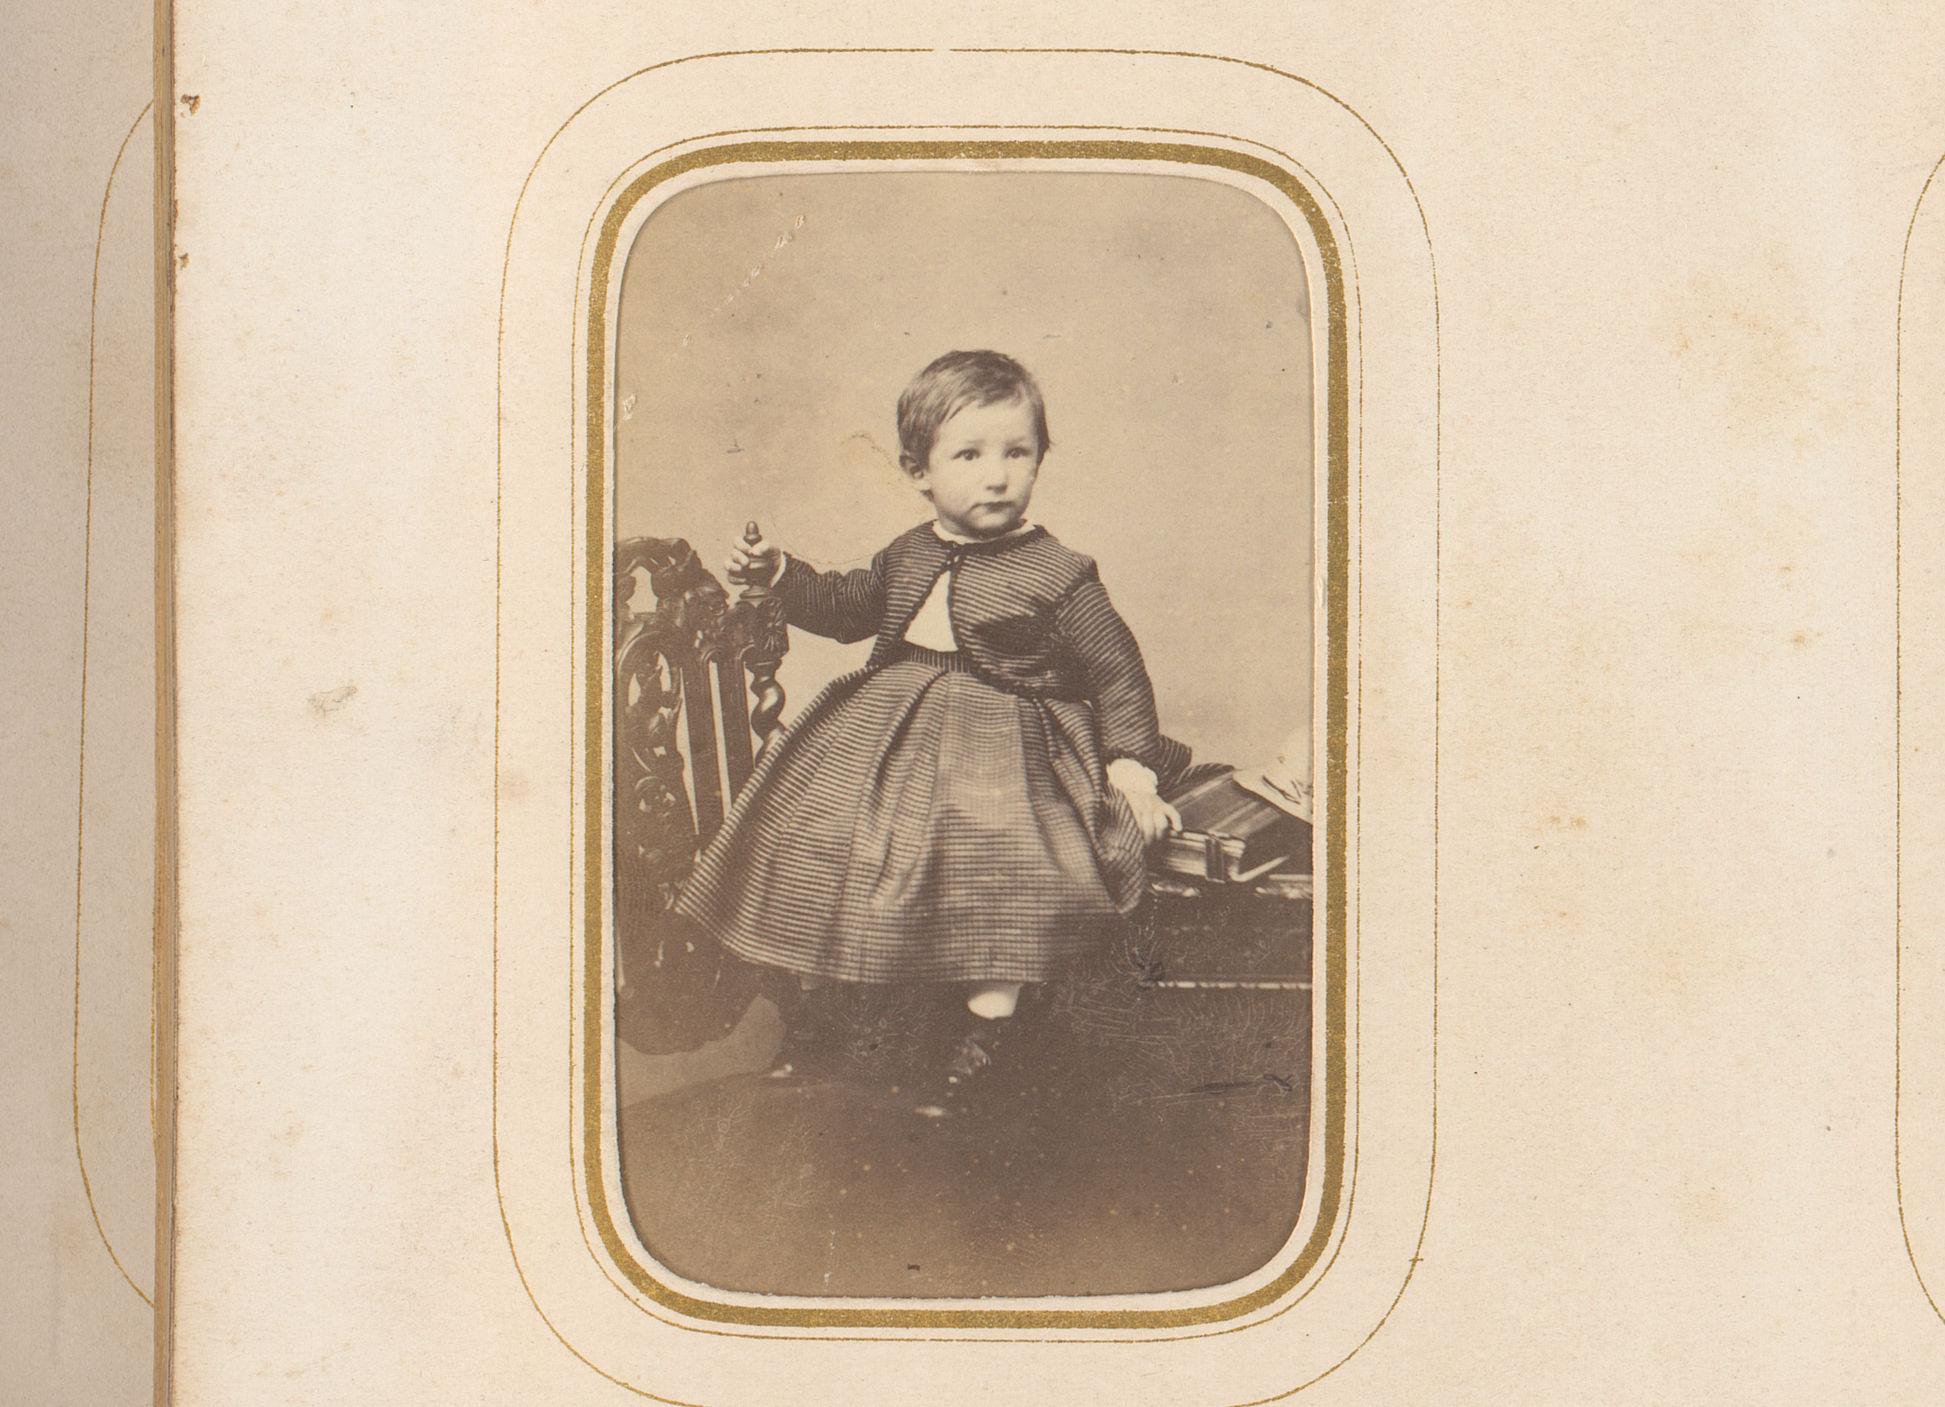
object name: photograph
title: Portret van een zittend kind met fotoalbum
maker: a. dupuy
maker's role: fotograaf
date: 1860-1900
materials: cardboard, photographic support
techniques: albumen print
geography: paris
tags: child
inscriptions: inscription: ‘A. Dupuy phot.’, inscription: ‘Photographie/ A. Dupuy/ 150, Rue de Rivoli/ Paris’